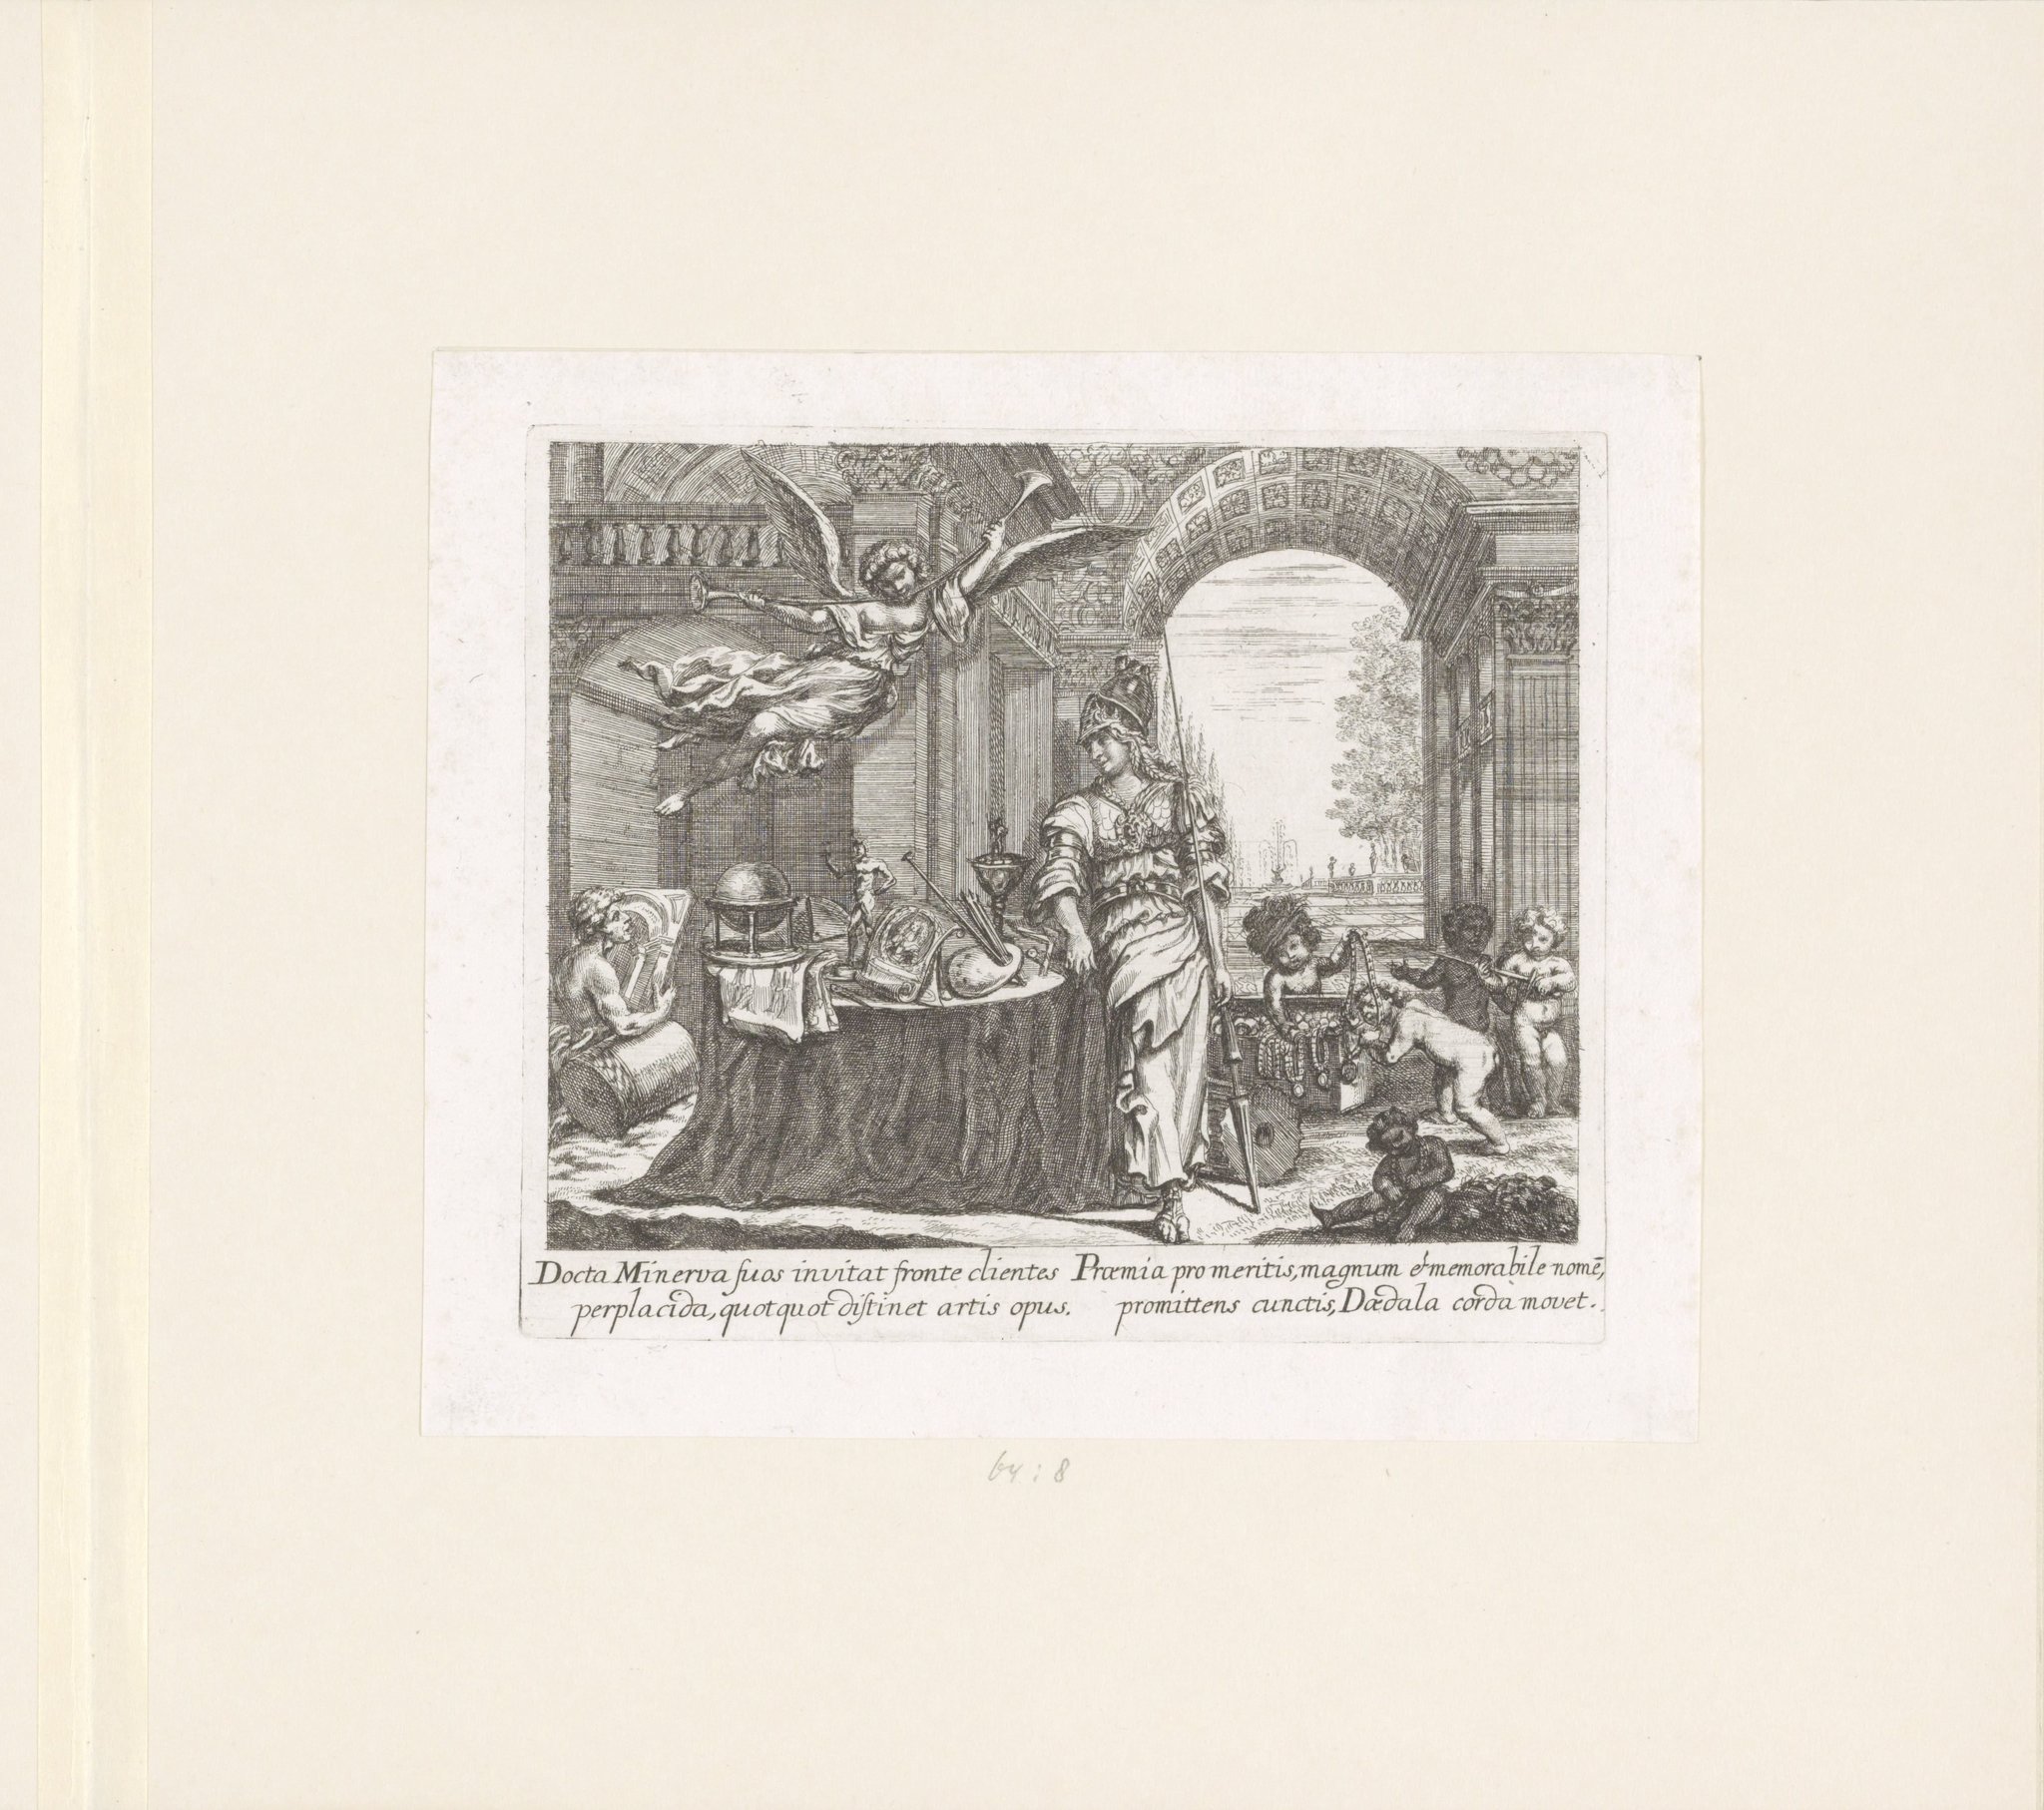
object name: album leaf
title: Minerva als beschermster der kunsten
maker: mathäus küsel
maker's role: print maker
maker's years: 1629-1681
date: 1680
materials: paper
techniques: etching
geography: augsburg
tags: minerva as patroness, tools, implements of graphic artist, tools, implements of painter, fame; 'fama', 'fama buona', 'fama chiara' (ripa)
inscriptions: collector's mark: Lugt 964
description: Minerva staat bij een tafel waarop verschillende attributen van de kunsten: een palet met kwasten, een zilveren bokaal, papieren met tekeningen, een globe, een kleine sculptuur en een burijn. Boven de tafel blaast Faam op twee bazuinen. Rechts putti met een kist erepenningen en een zwaard. Onder de voorstelling vier regels tekst in het Latijn. De prent maakt deel uit van een album.